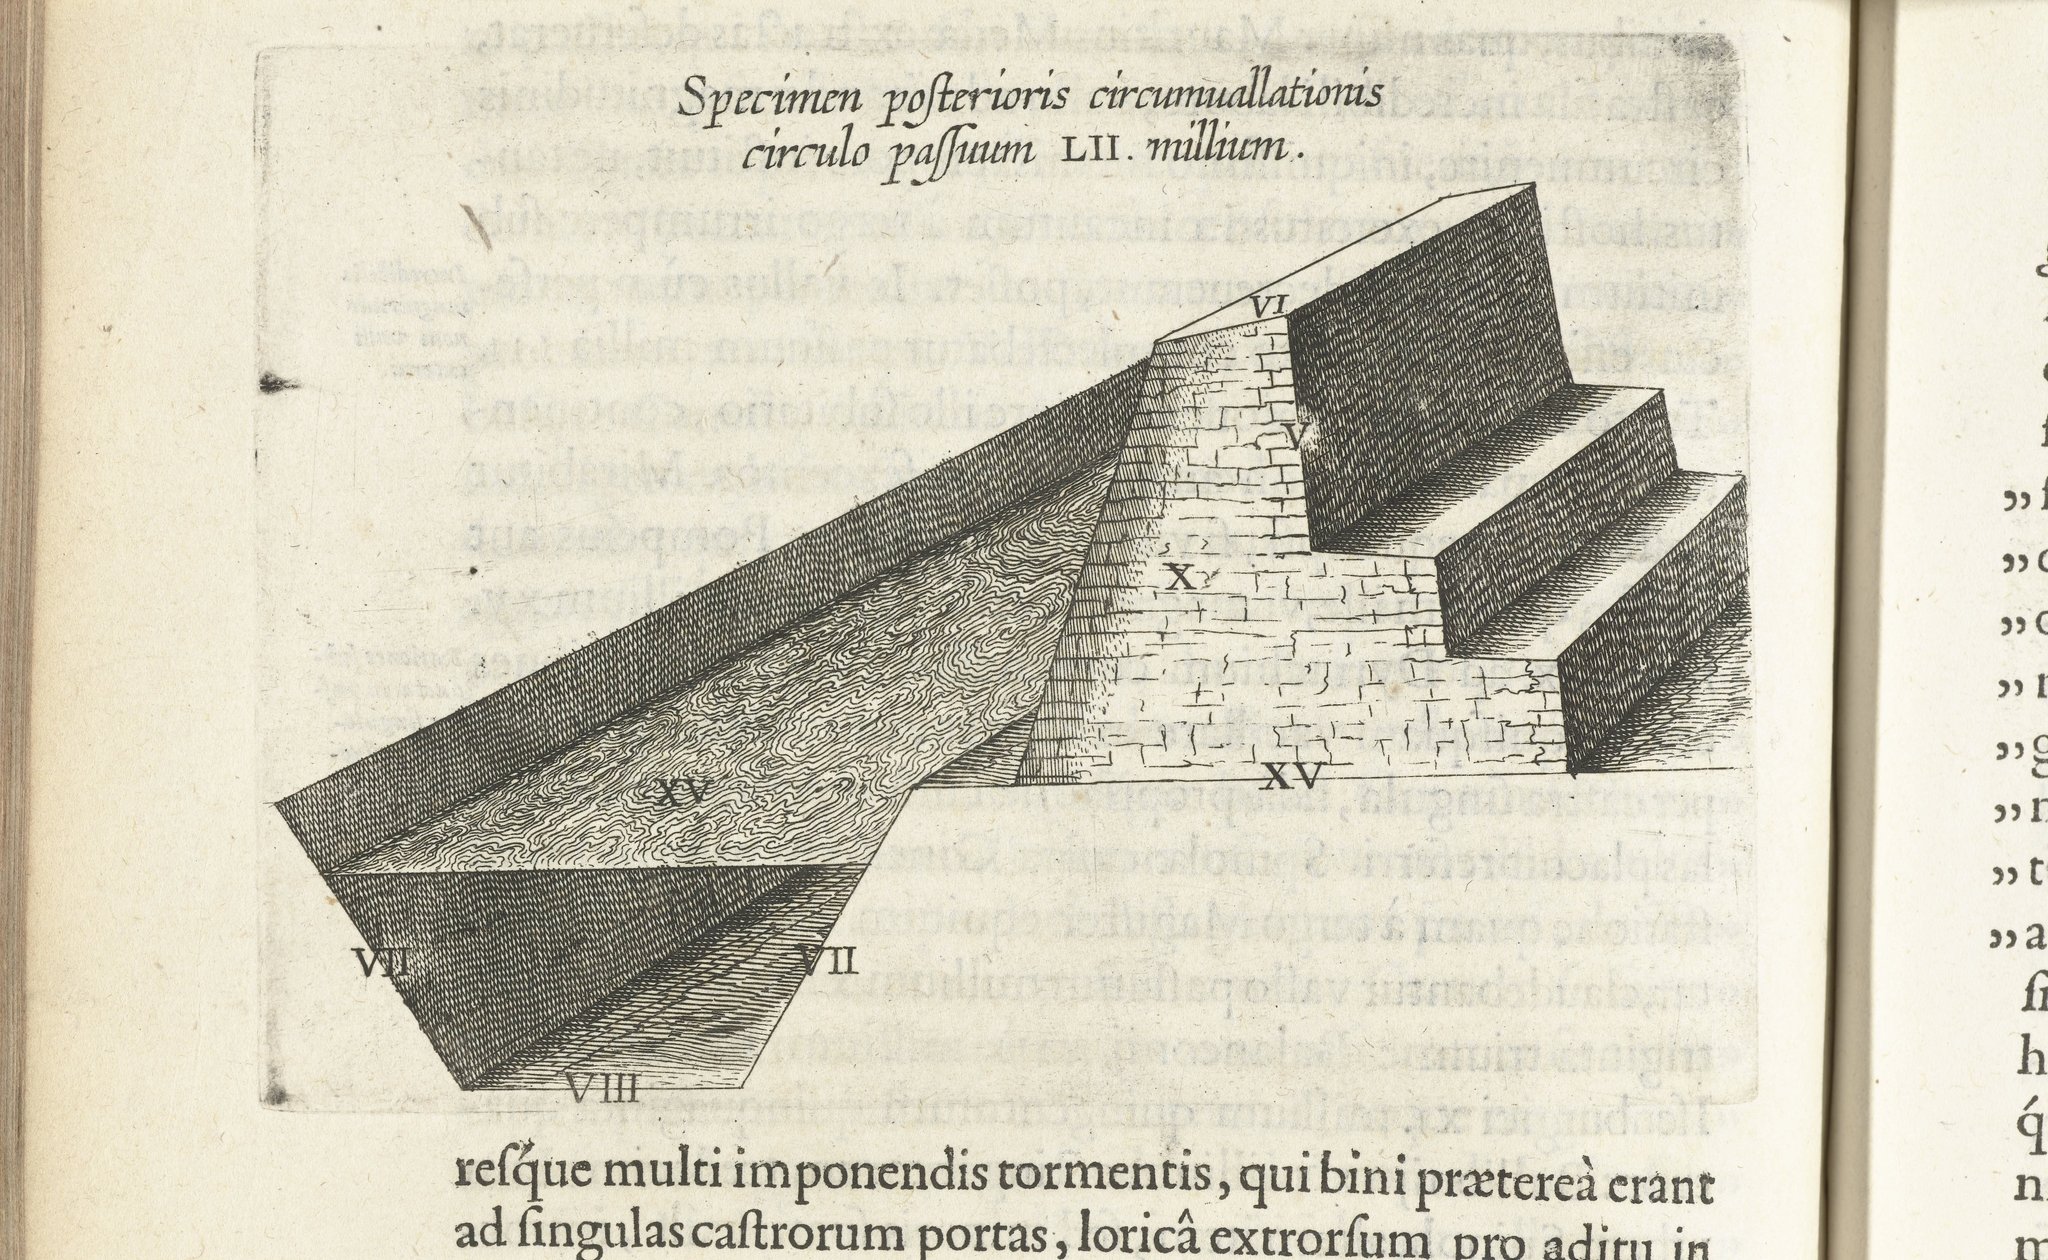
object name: print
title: Specimen posterioris circumvallationis circulo passuum LII. millium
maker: Anonymous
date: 1625-1626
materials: paper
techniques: etching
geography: southern netherlands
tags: fortifications, military engineering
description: Illustratie in: Hermannus Hugo, Obsidio Bredana armis Philippi IIII avspiciis Isabellae Dvctv Ambr. Spinolae perfecta, ex off. Plantiniana, Antwerpen 1629, p. 78. Exemplaar in de collectie van de Rijksmuseum Research Library met signatuur 327 I 25. In M. Funck, Le livre belge à gravures : guide de l'amateur de livres illustrés imprimés en Belgique avant le XVIIIe siècle (1925) worden deze illustraties toegeschreven aan Theodoor Galle (11) en Schelte en Boëtius Bolswert (4). Ze worden echter in Hollstein niet bij deze prentmakers vermeld.